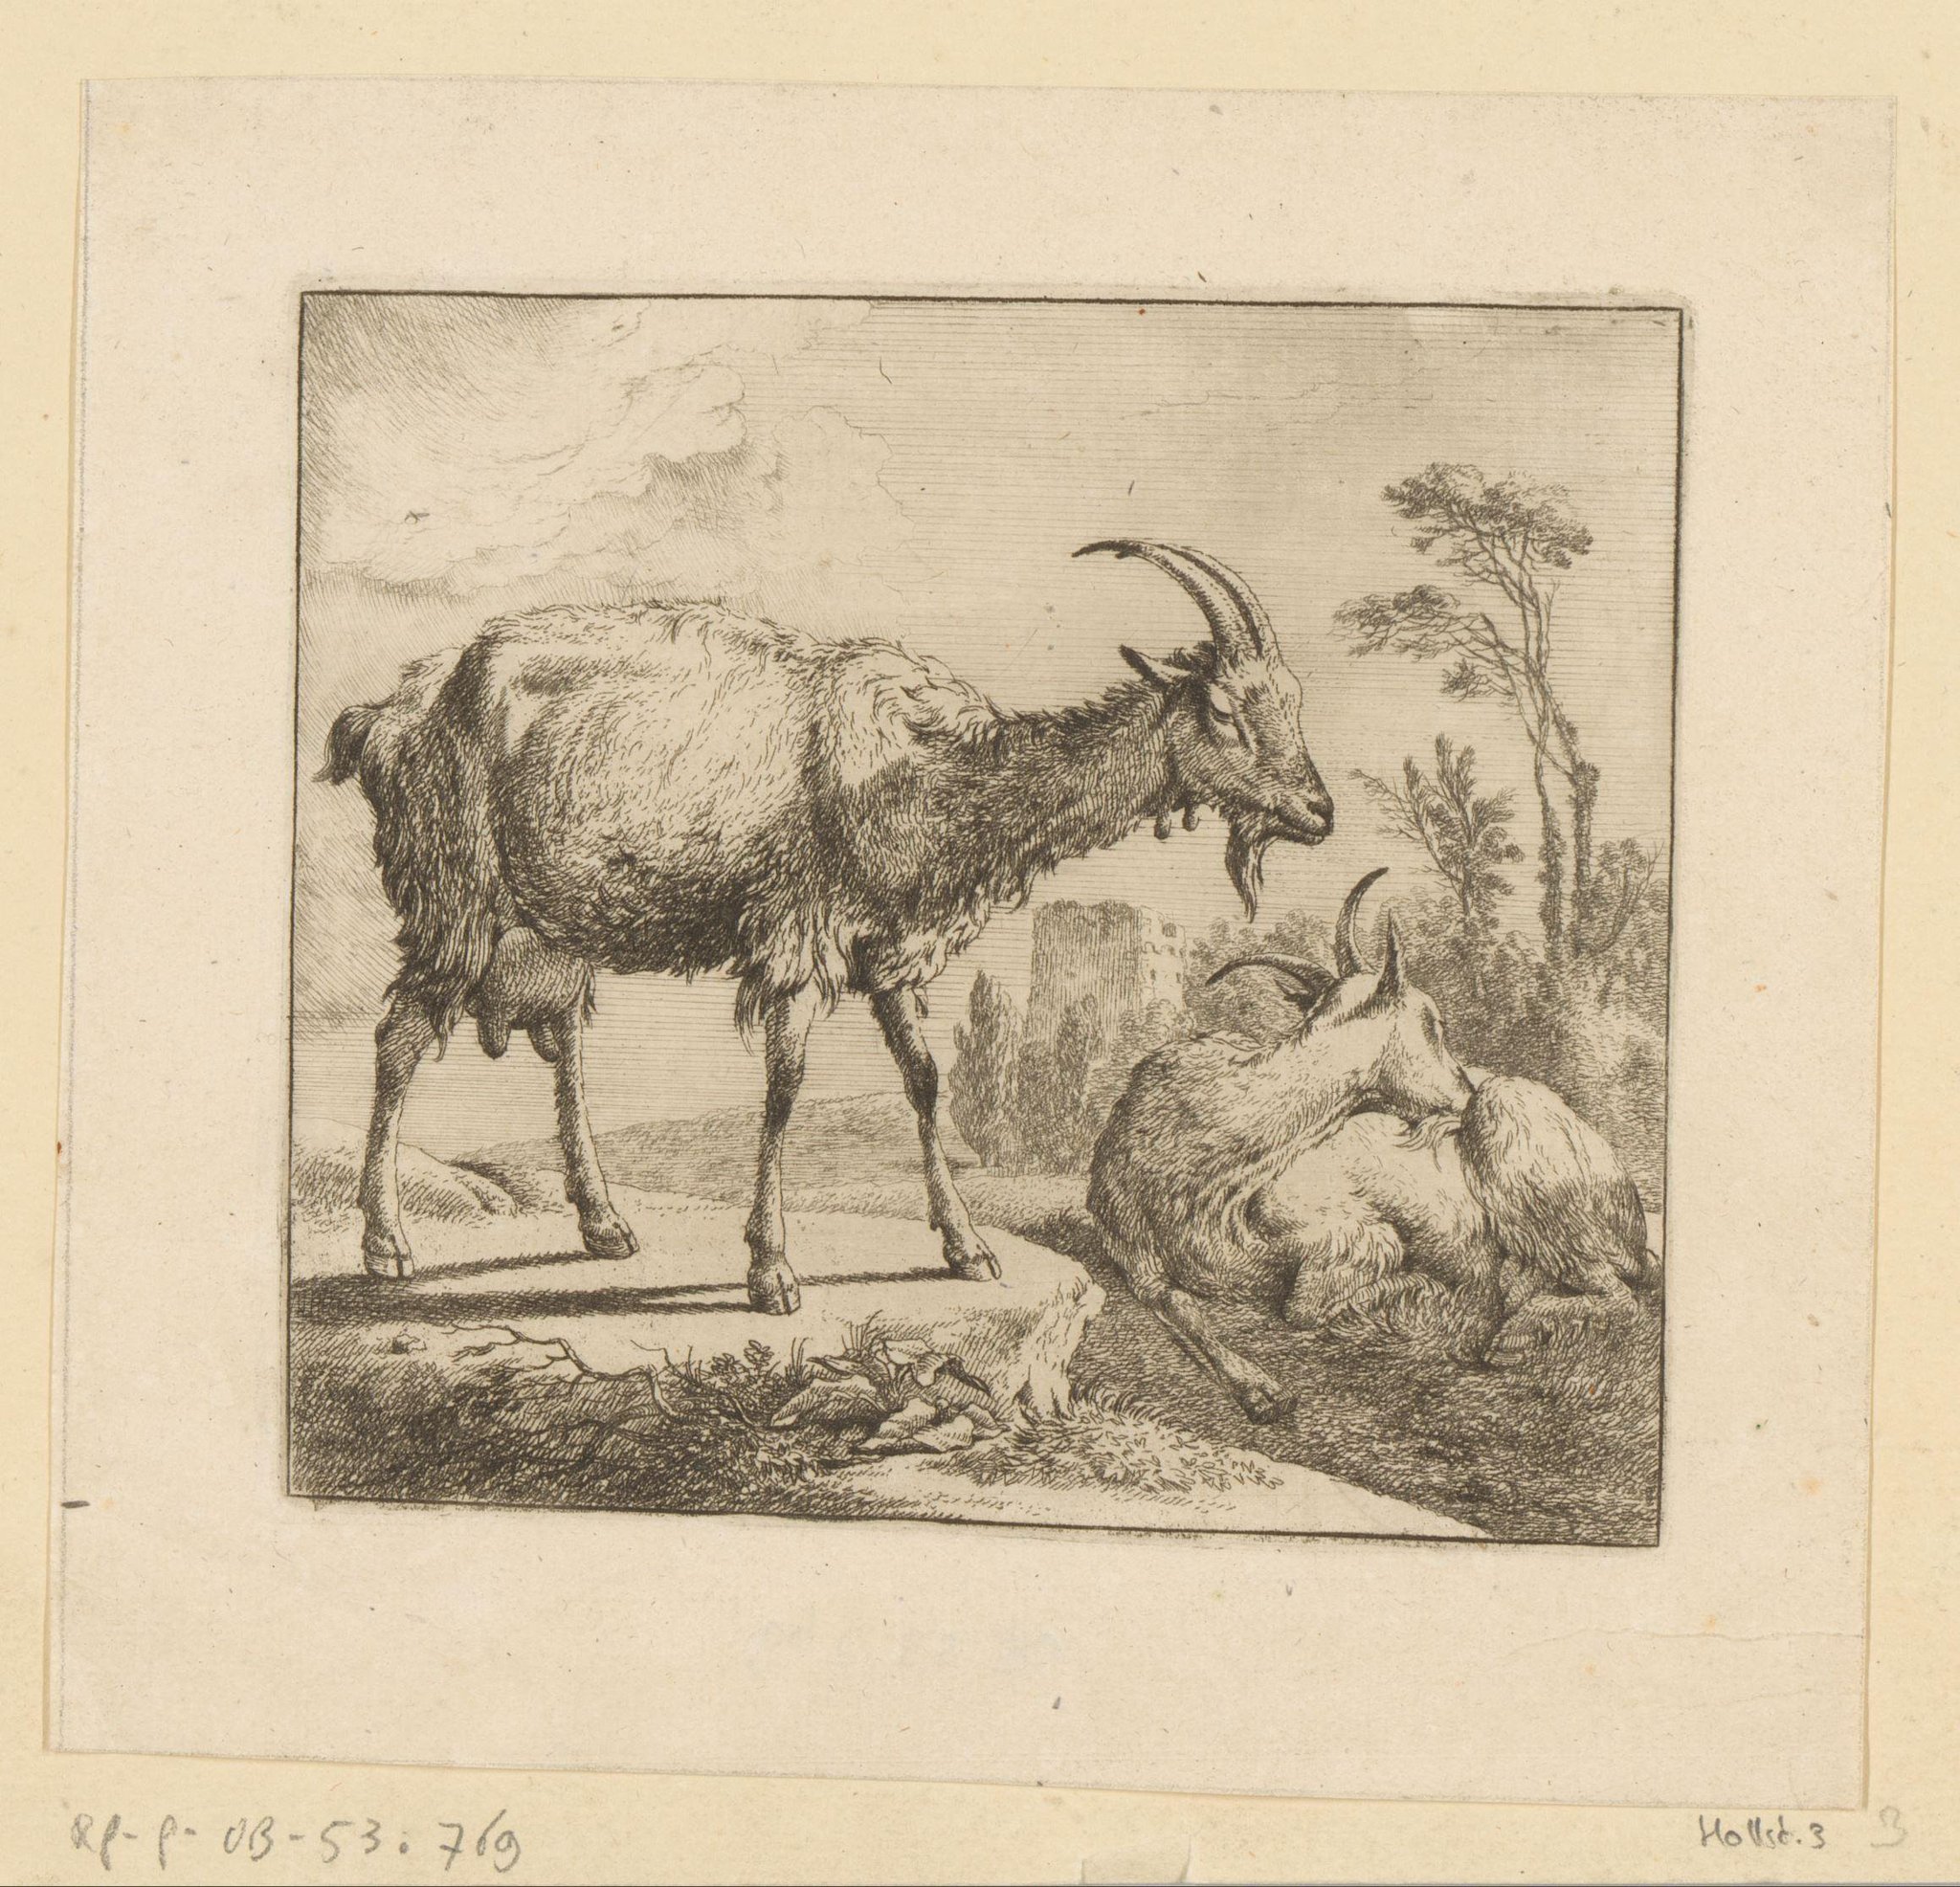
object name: print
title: Staande en liggende geit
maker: johann heinrich roos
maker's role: draughtsman, print maker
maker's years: 1631-1685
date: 1671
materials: paper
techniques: engraving, etching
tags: landscapes, goat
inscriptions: collector's mark: Lugt 240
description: Serie van negen prenten, waarvan één titelprent. Allen in de tweede, met de burijn bijgewerkte, staat.